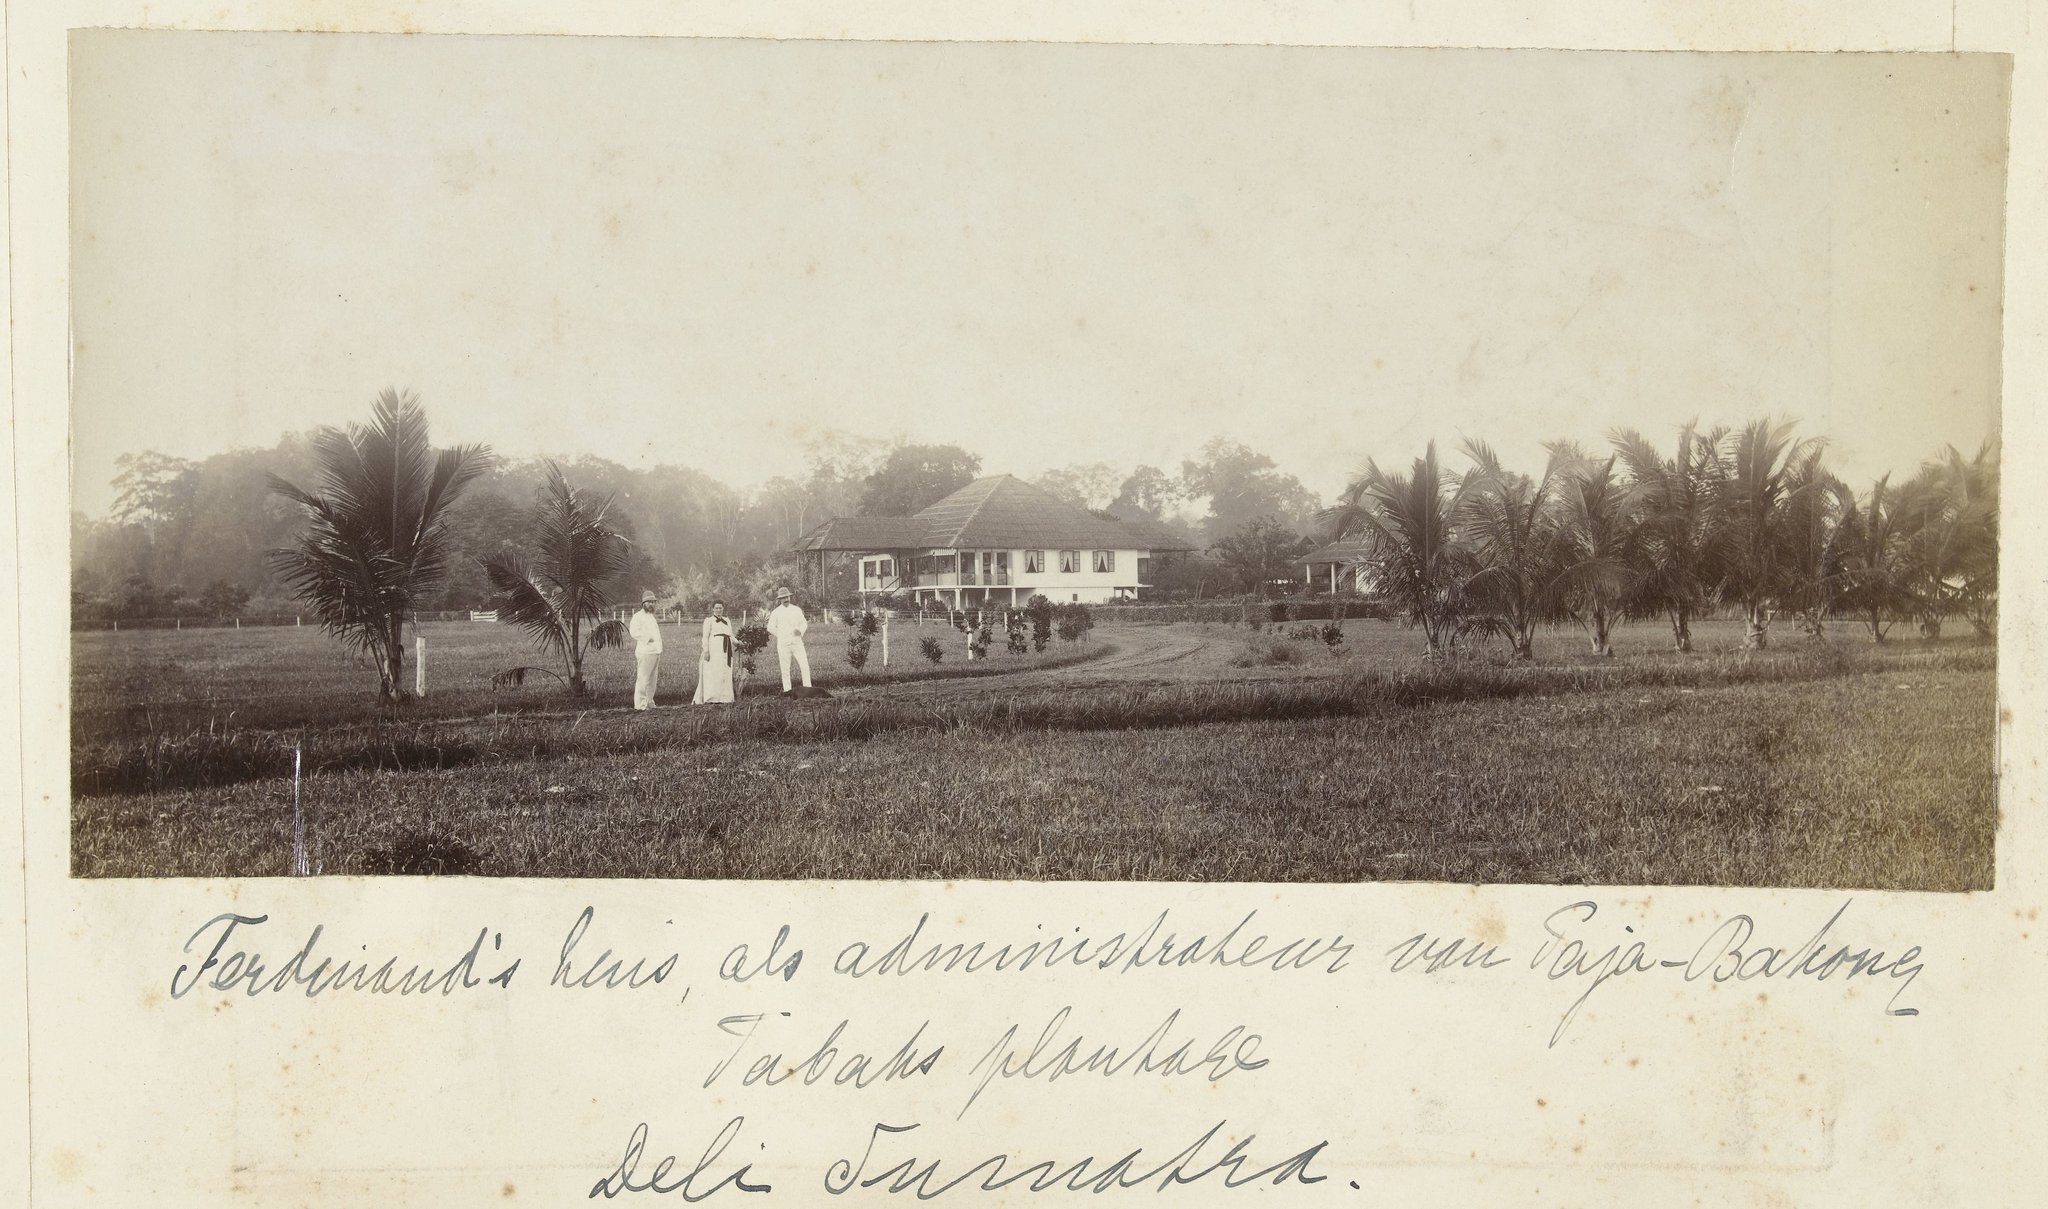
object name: photograph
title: Adminstrateurs woning van Delimaatschappij op Paya Bakong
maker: Anonymous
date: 1890-1910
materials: cardboard, paper, photographic support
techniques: gelatin silver print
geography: singapore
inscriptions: caption: ‘Ferdinand's huis, als administrateur van Paja-Bakong Tabaksplantage Deli Sumatra’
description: Voor de woning poseren twee mannen en een vrouw, allen in het wit gekleed, de mannen dragen een tropenhelm.